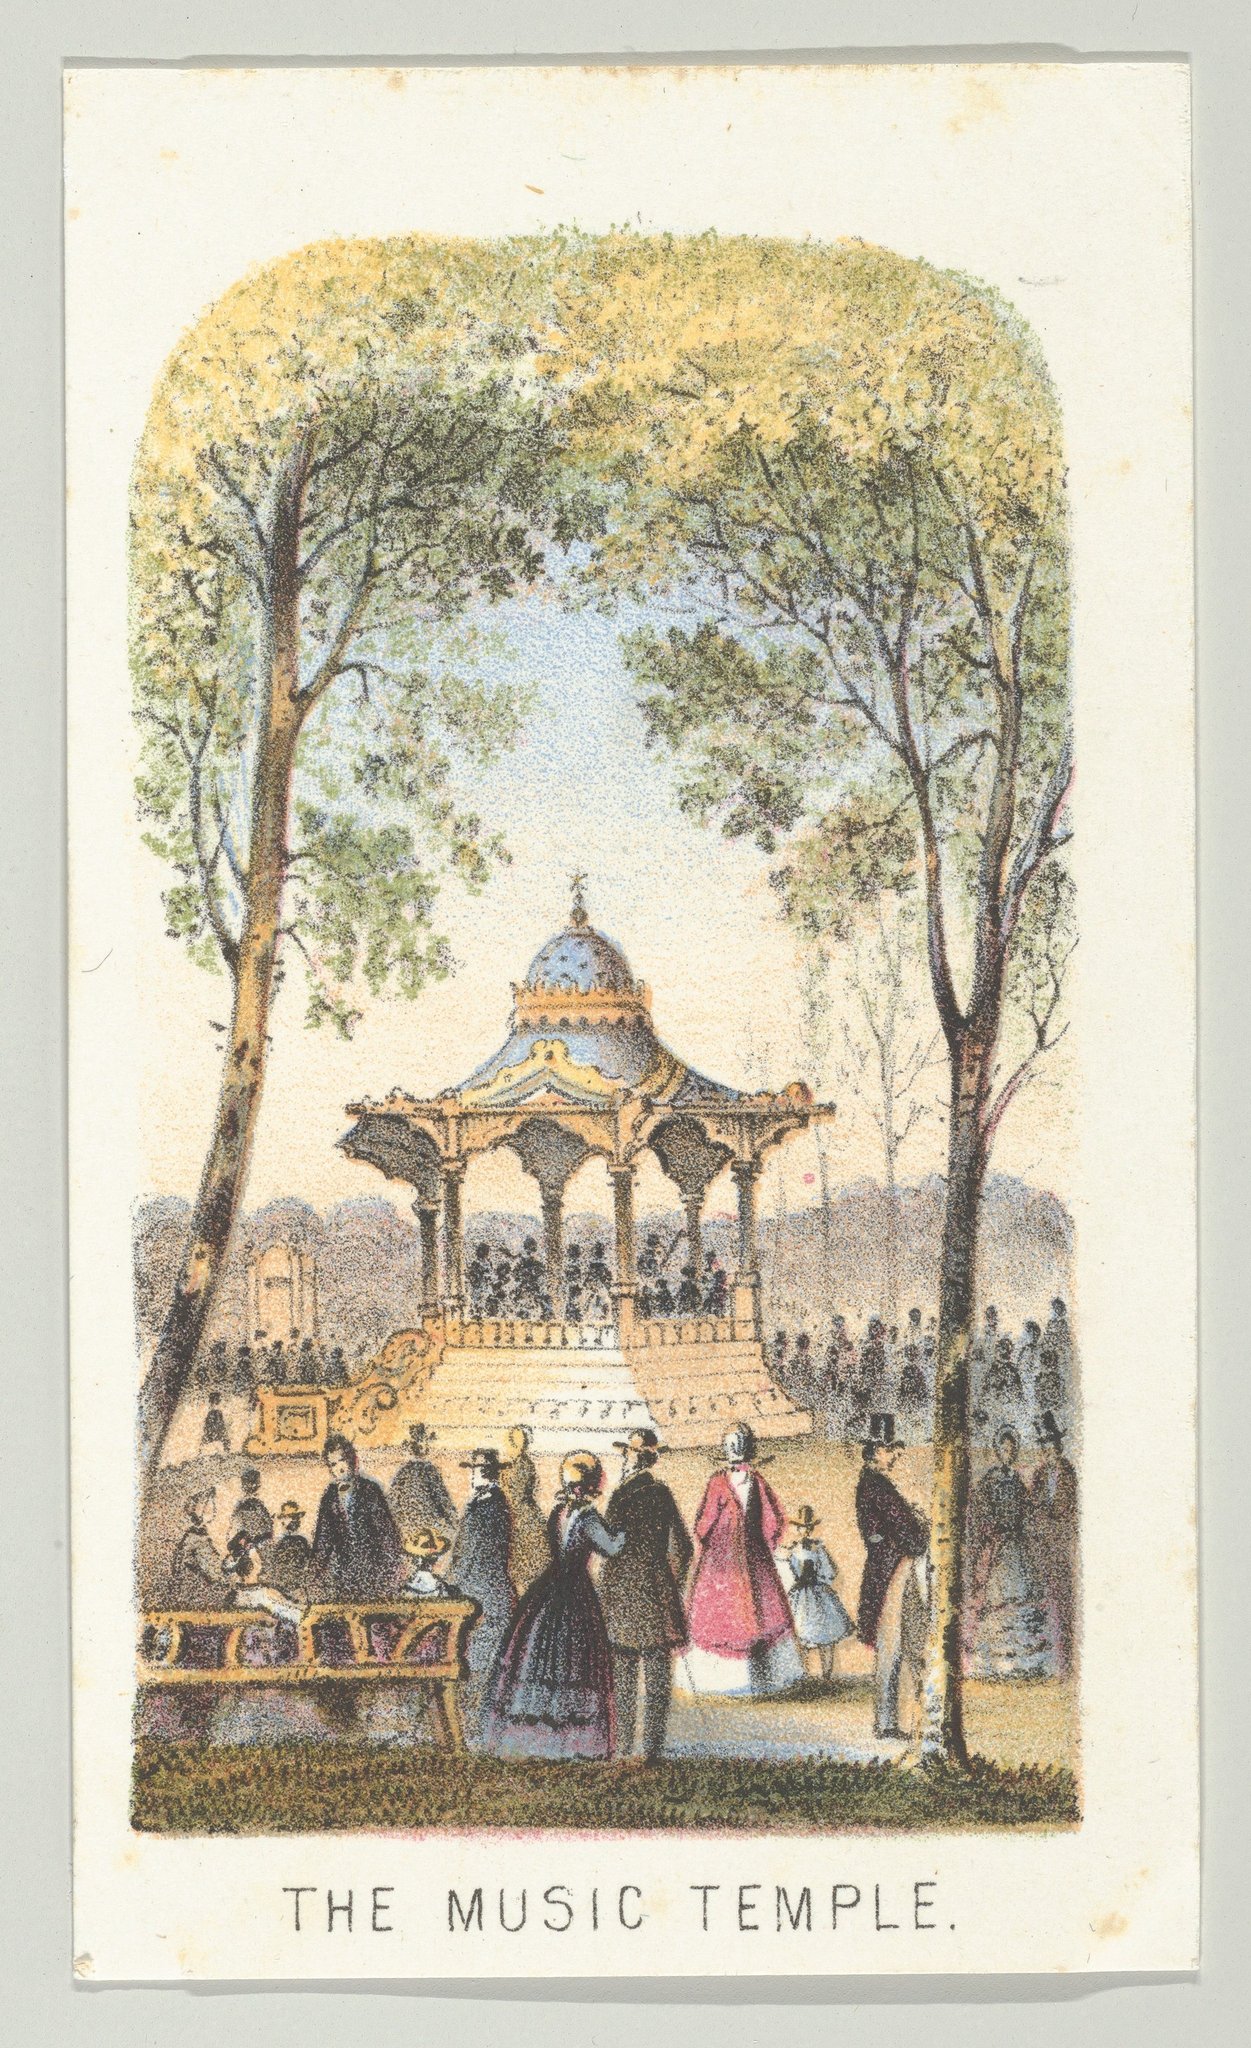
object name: print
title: The Music Temple, from the series, Views in Central Park, New York, Part 2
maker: louis prang & co.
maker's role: publisher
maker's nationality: american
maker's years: 1800-1950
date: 1864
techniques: lithograph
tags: temples,men,women